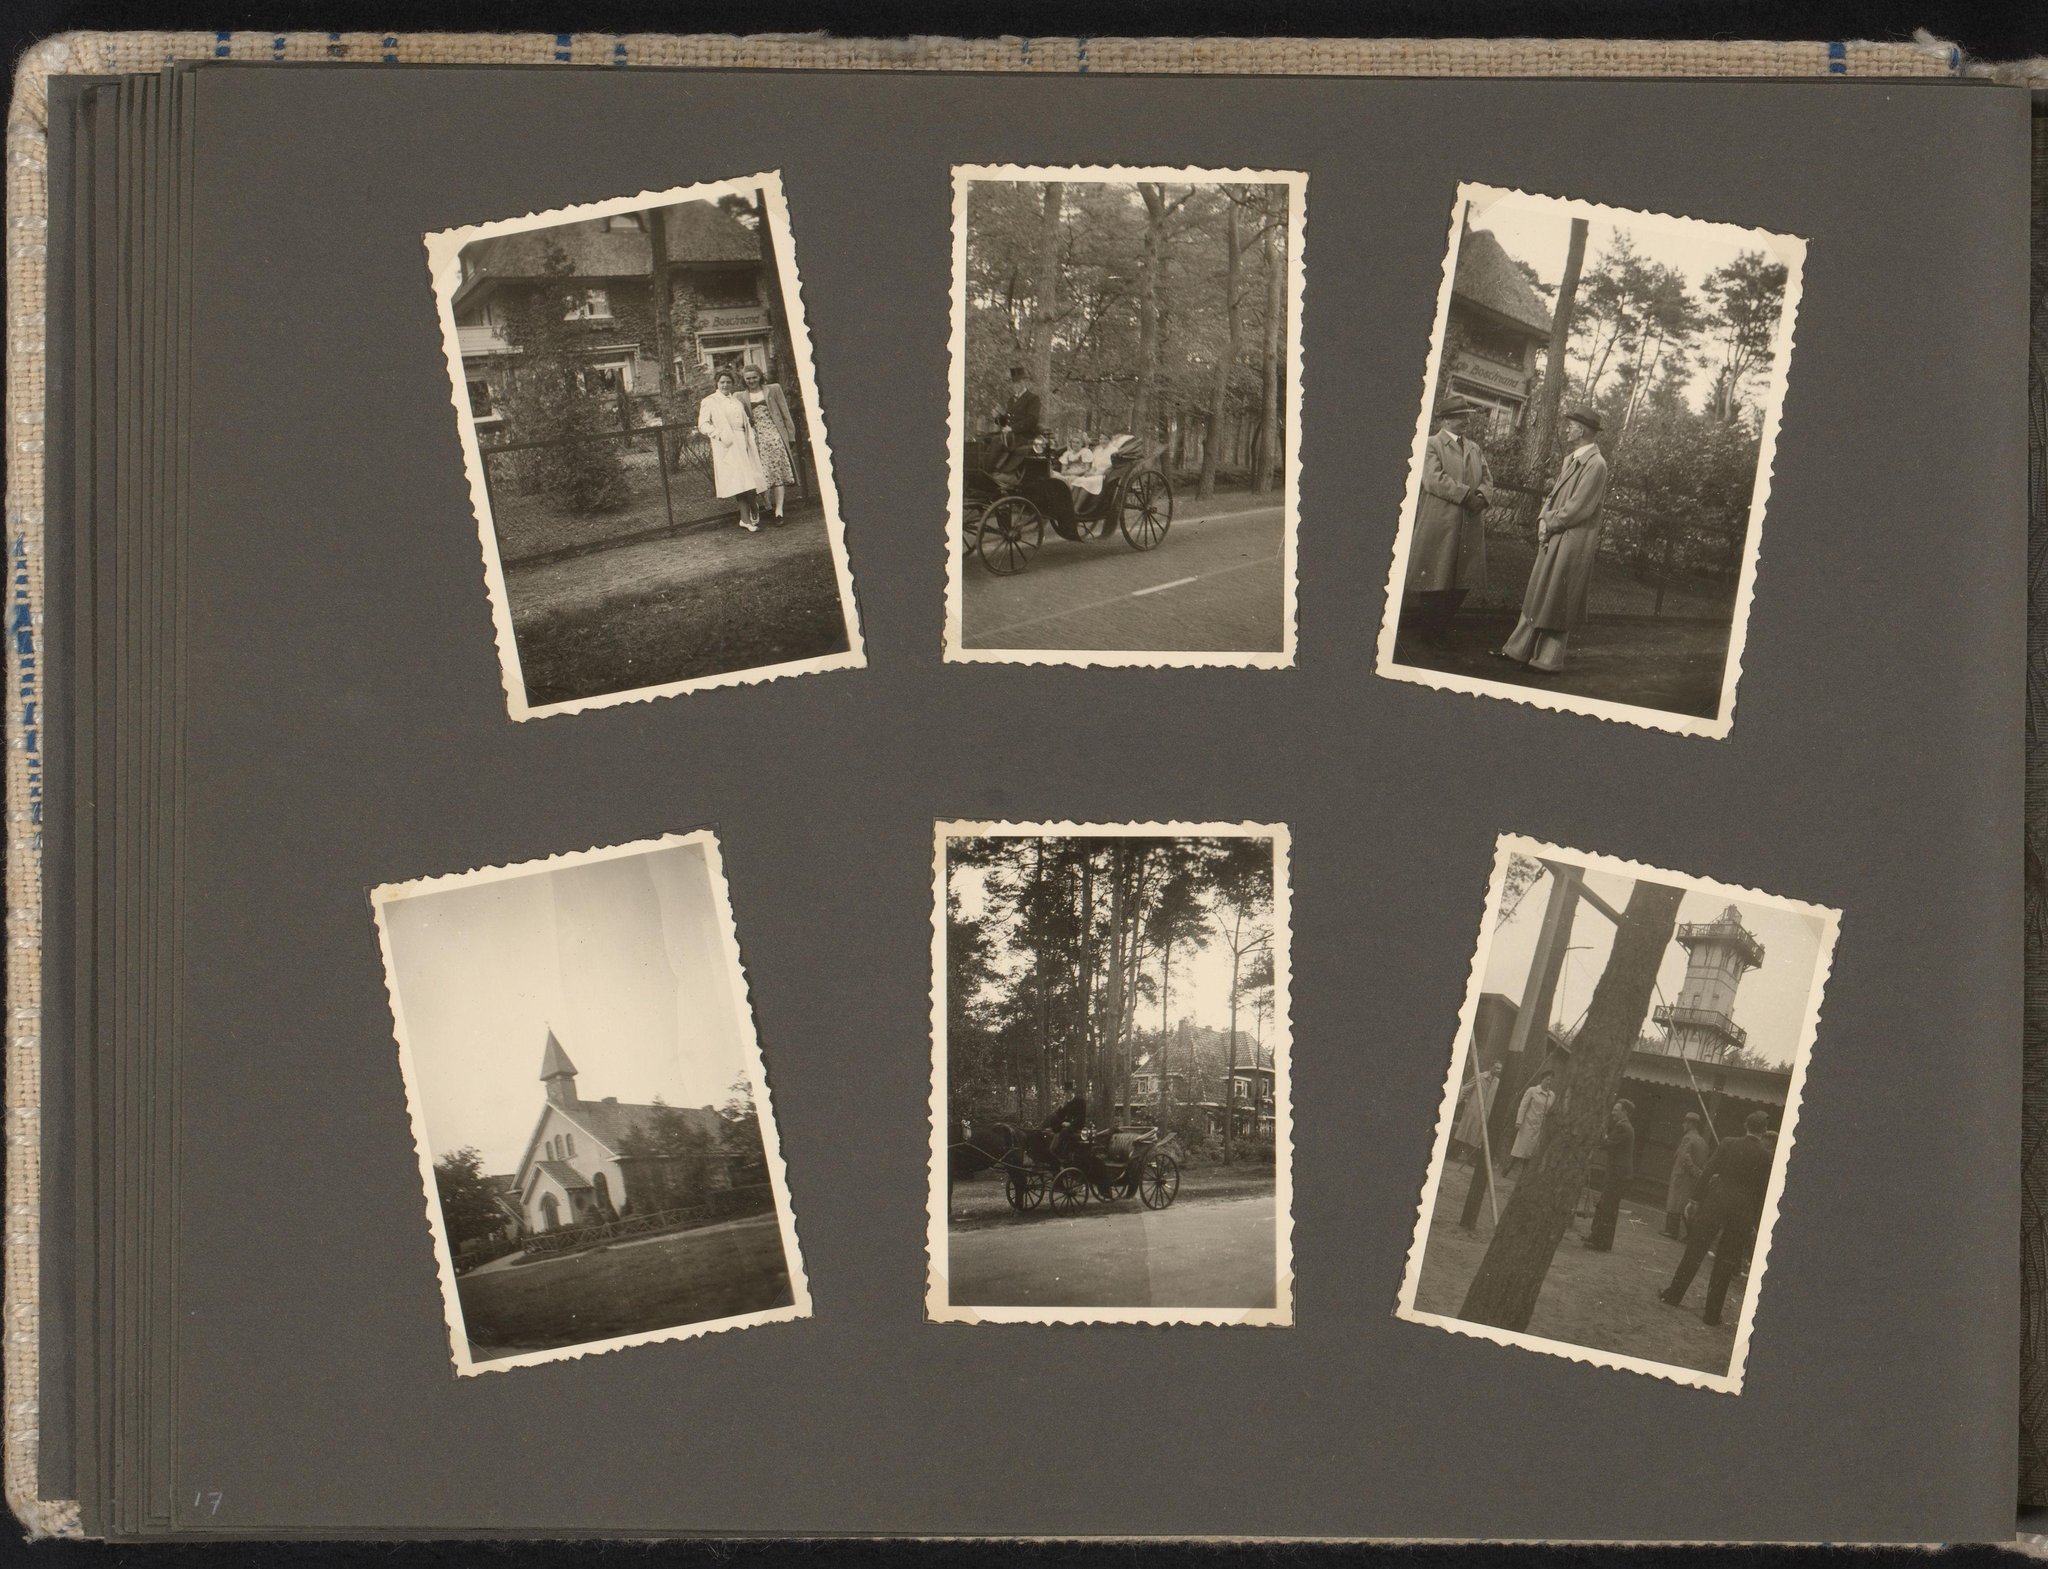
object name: album leaf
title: Paard en wagen en speeltuin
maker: Anonymous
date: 1941-1942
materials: cardboard, photographic support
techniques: gelatin silver print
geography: netherlands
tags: the soldier off duty, occupation ~ war, playground, wood and park (as places of recreation), netherlands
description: Albumblad met zes foto's van een uitje met familie en vrienden, met een rit in een open wagen en bezoek aan een speeltuin bij een bos. Onderdeel van het fotoalbum Abrechnungsintendantur van de Wehrmacht 1941-1943.